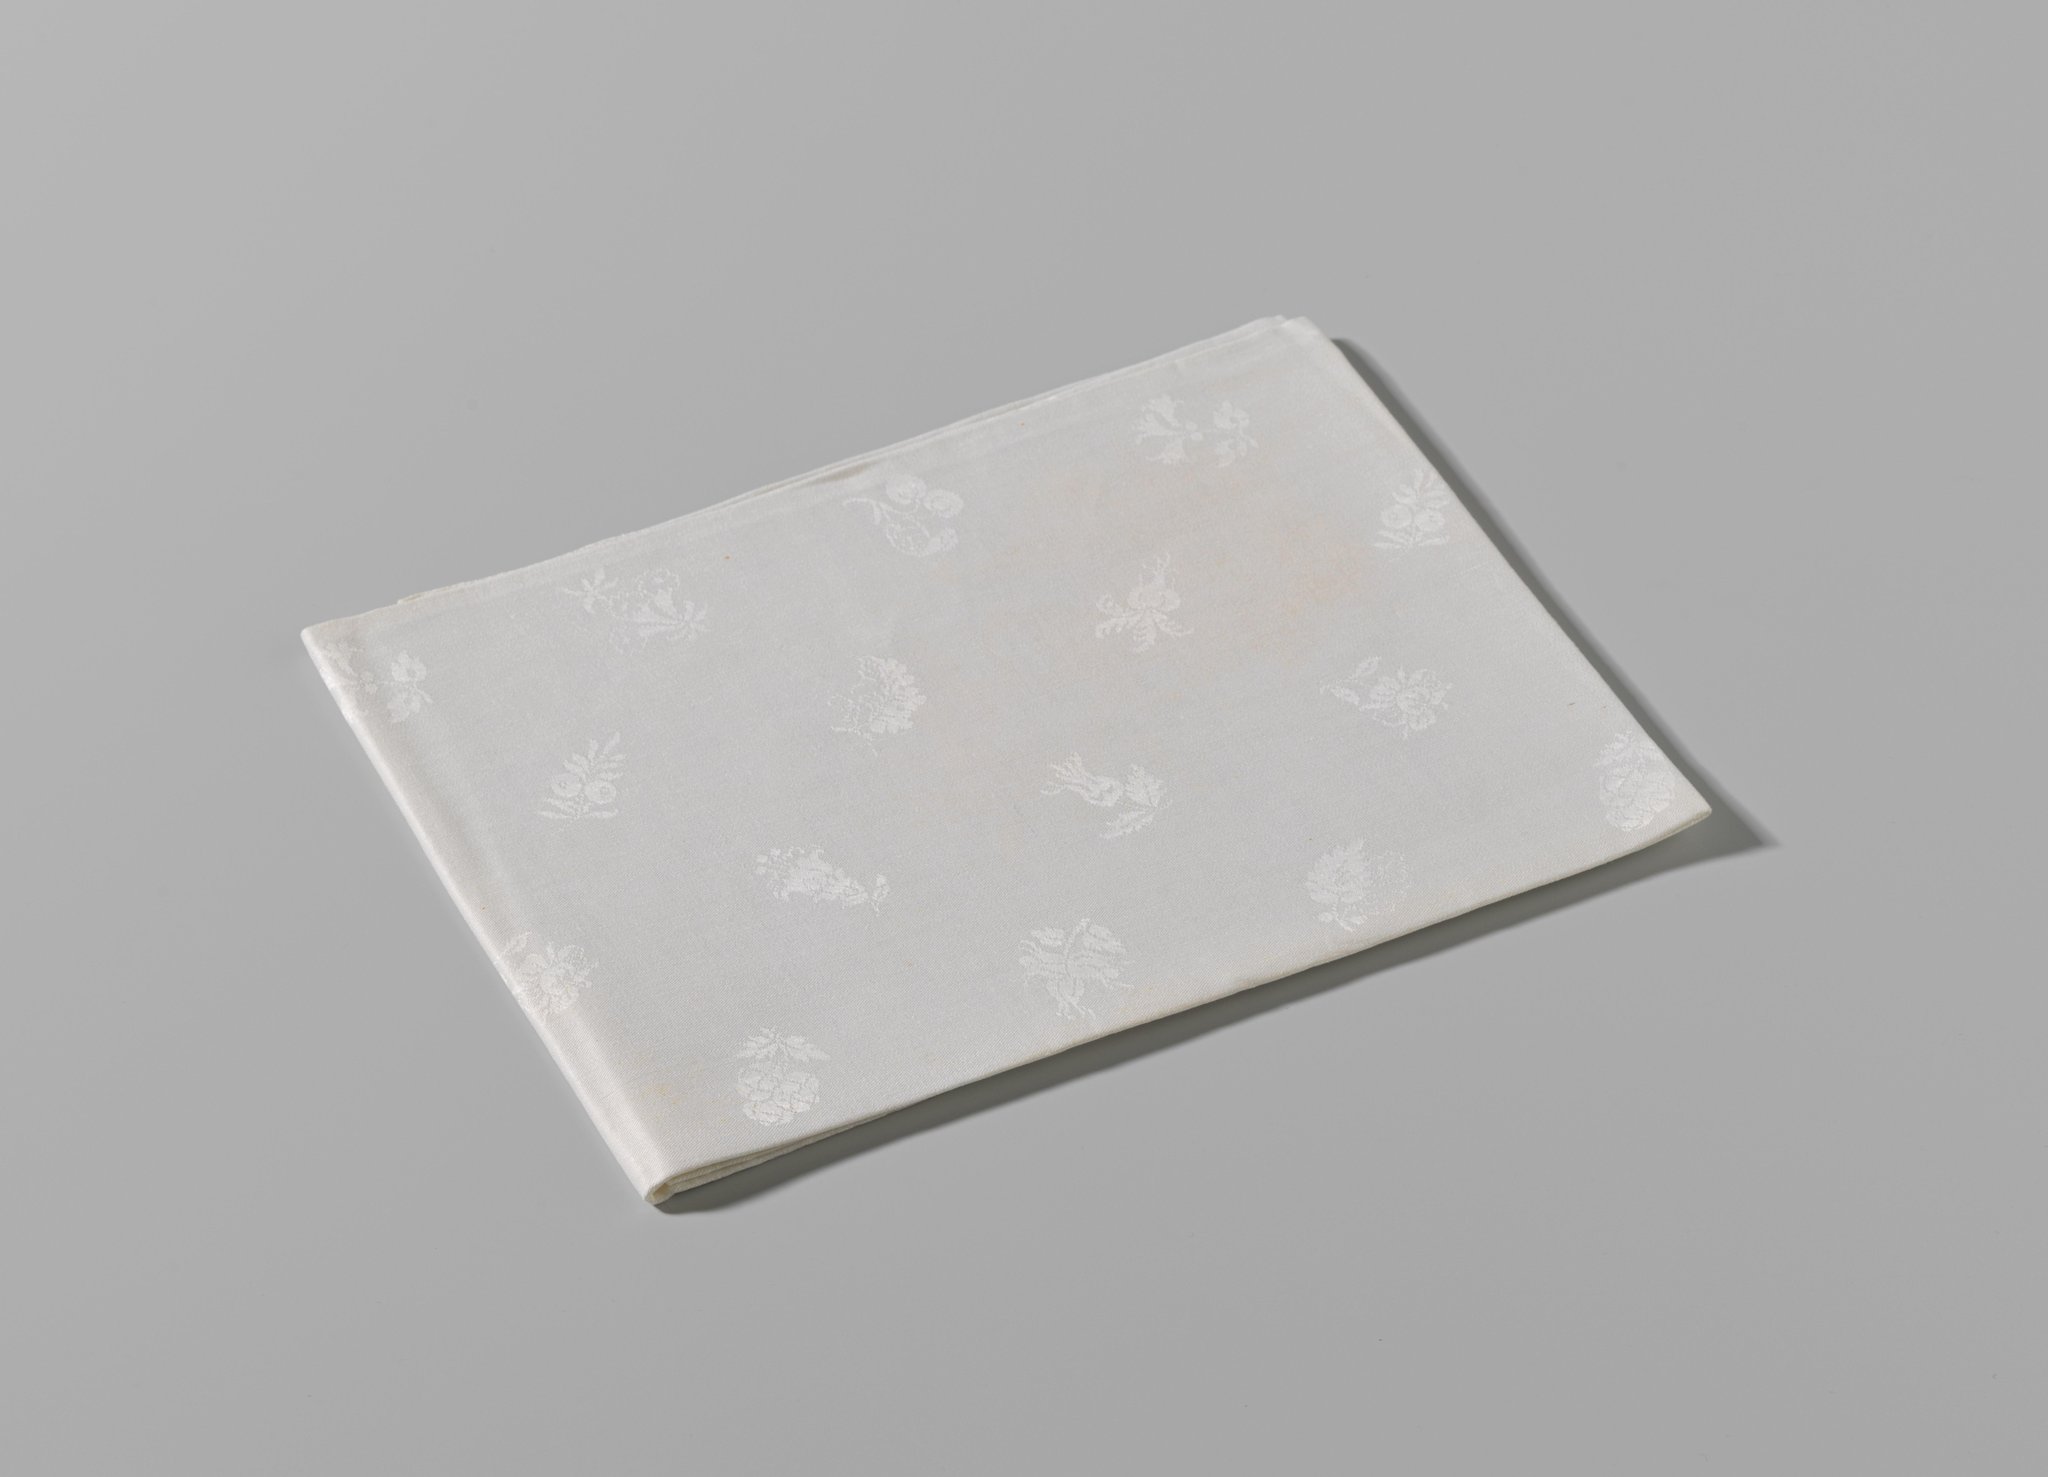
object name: napkin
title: Servet met patroon van diverse vruchten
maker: Anonymous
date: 1800-1900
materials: linen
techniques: damask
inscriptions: label: ‘R.M. A'dam’, monogram: ‘TvBF’, mark: ‘36’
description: Servet van linnendamast met patroon van diverse vruchten en bloemen op het middenveld.